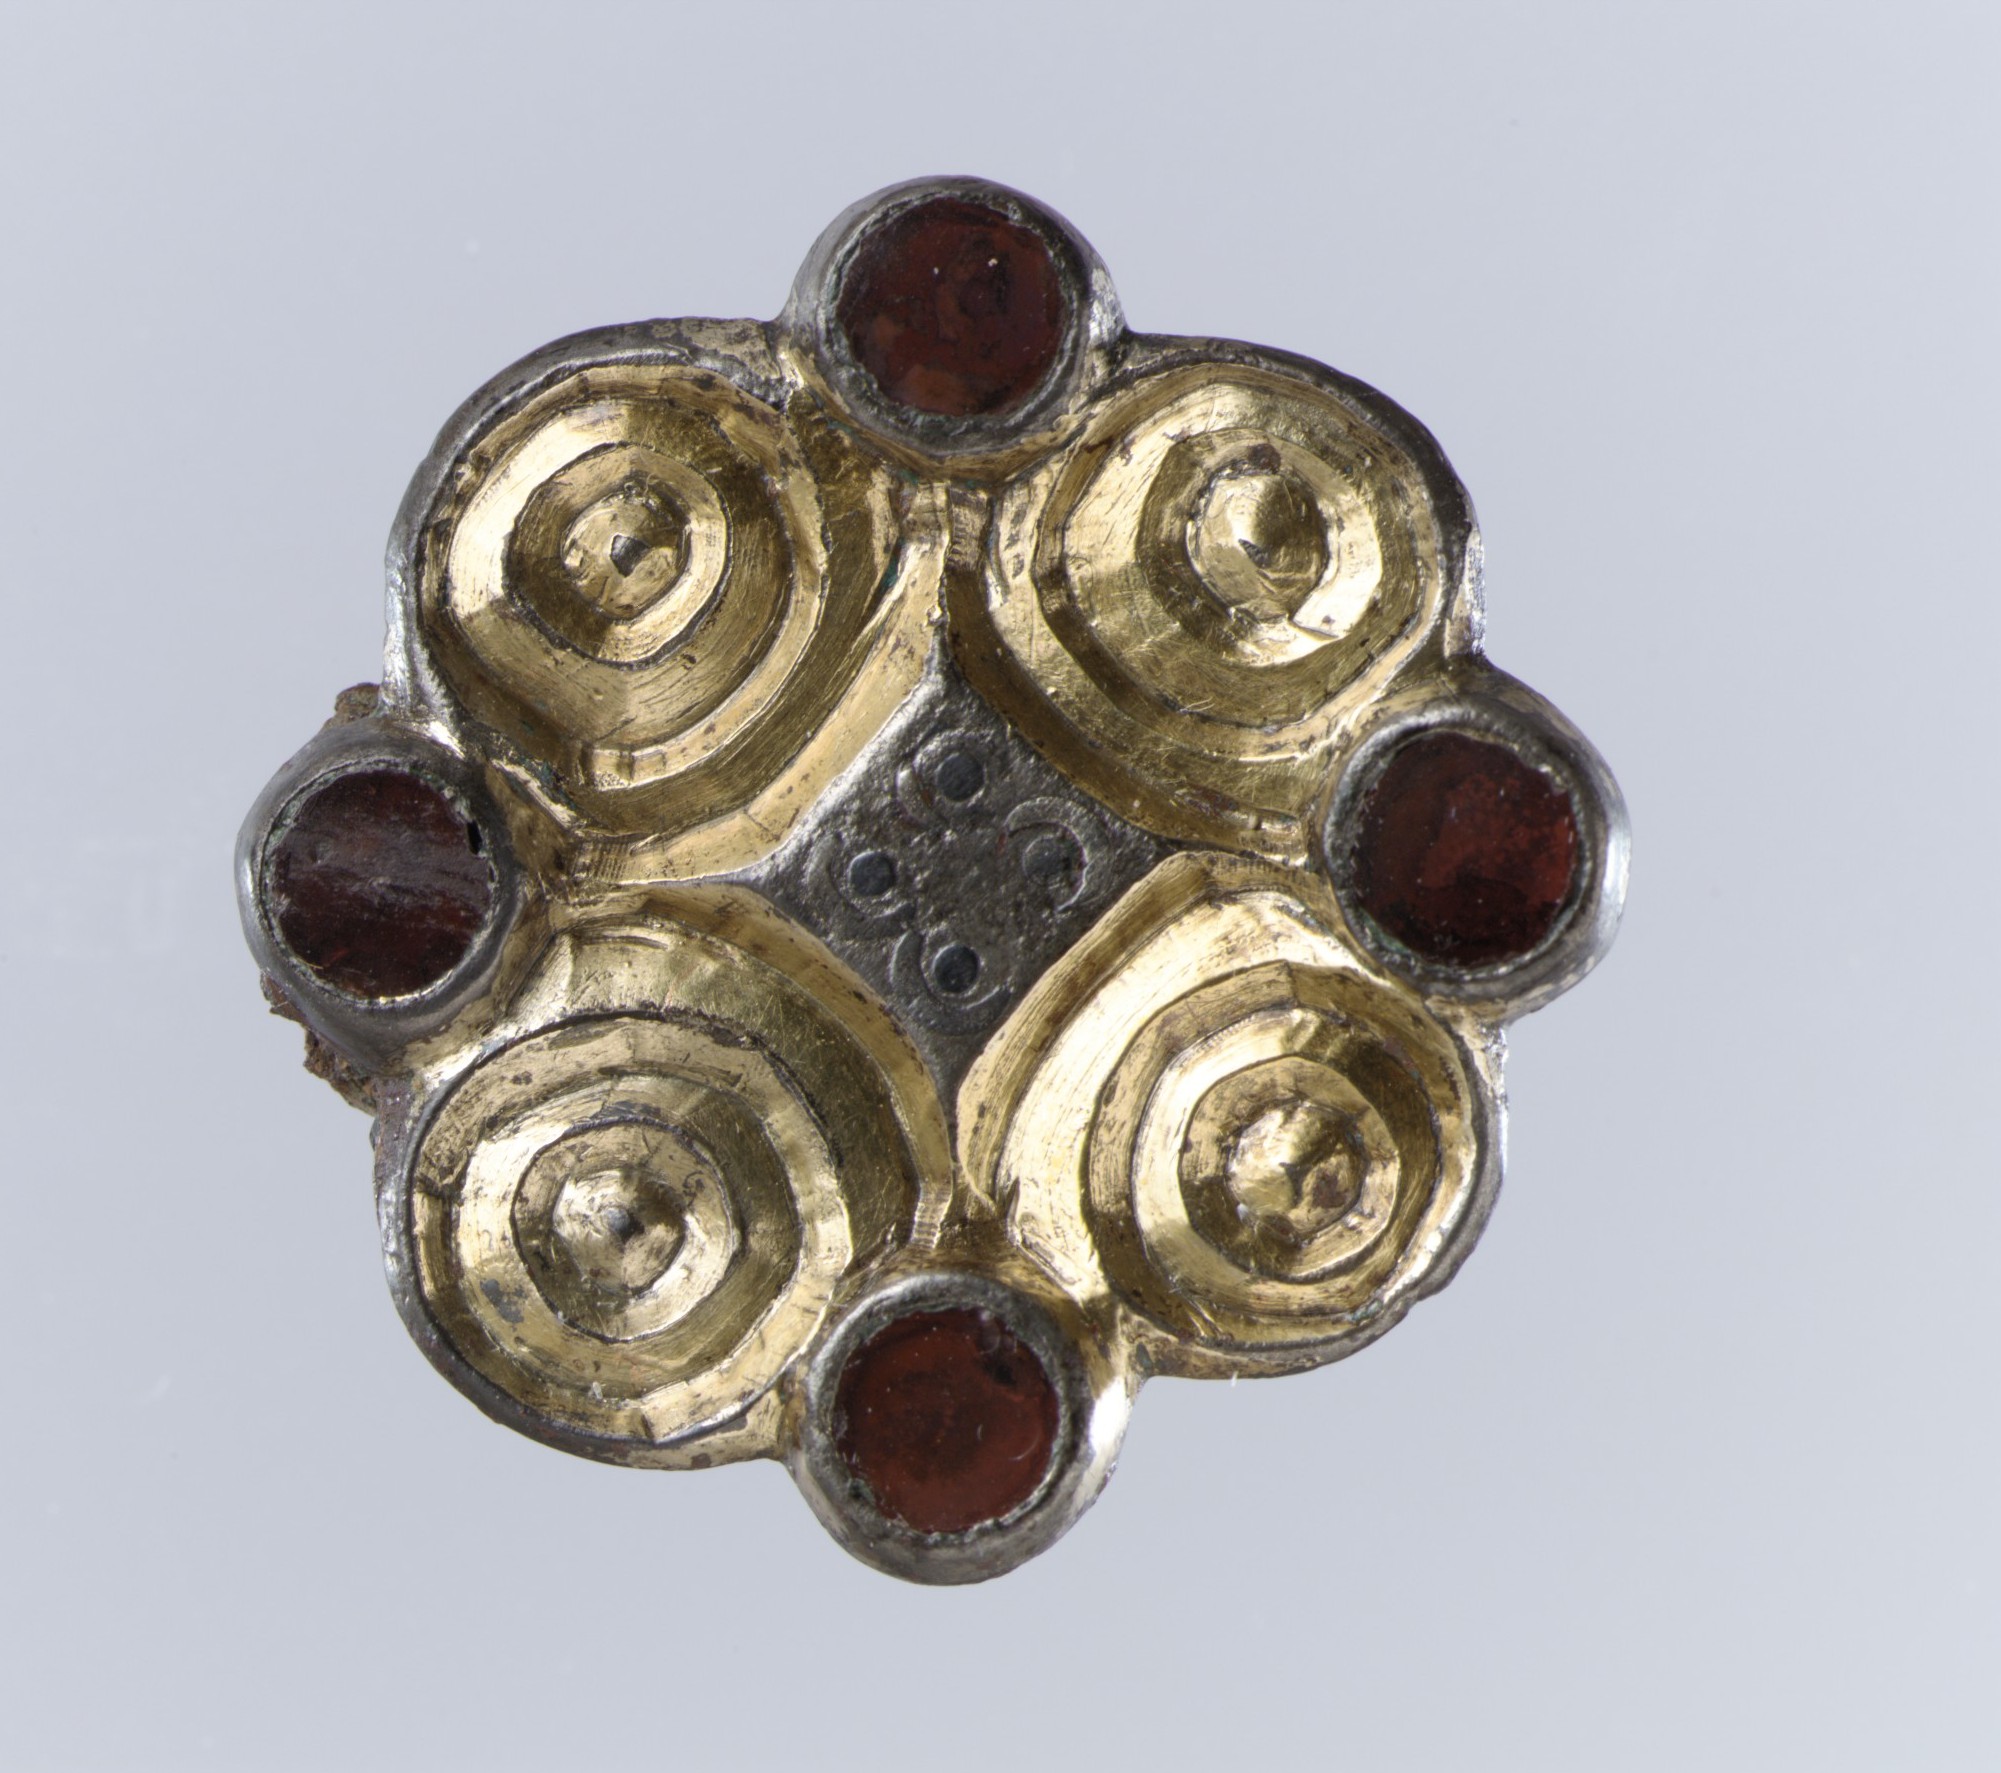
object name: brooch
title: Rosette Brooch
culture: frankish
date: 550-600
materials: gemstone, niello, silver gilt